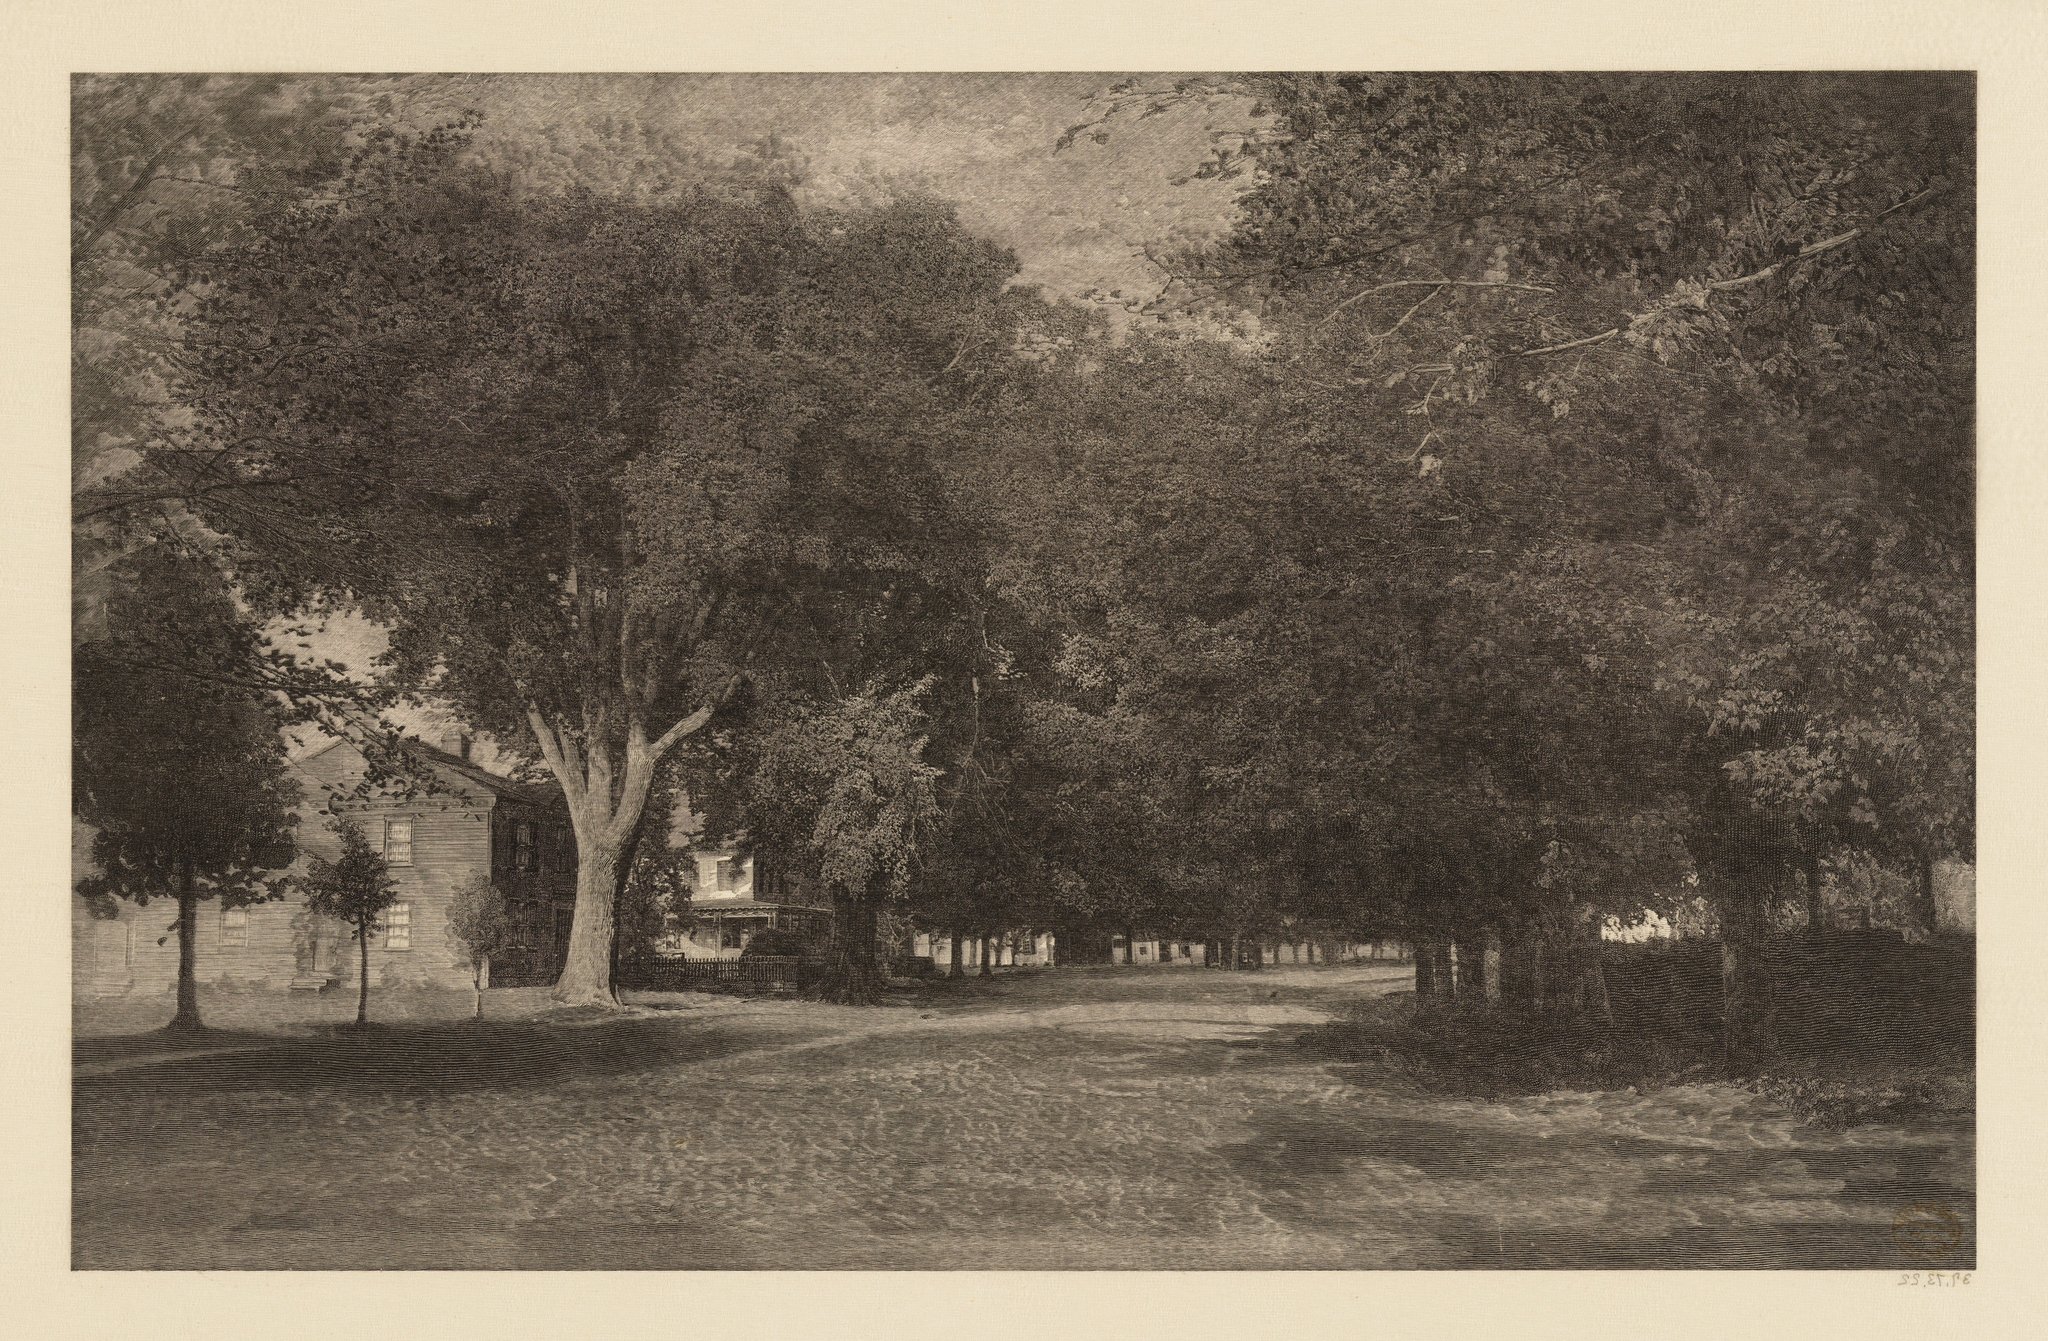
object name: print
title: New England Elms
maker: elbridge kingsley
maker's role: artist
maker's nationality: american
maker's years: 1841-1918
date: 1889-1890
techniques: engraving